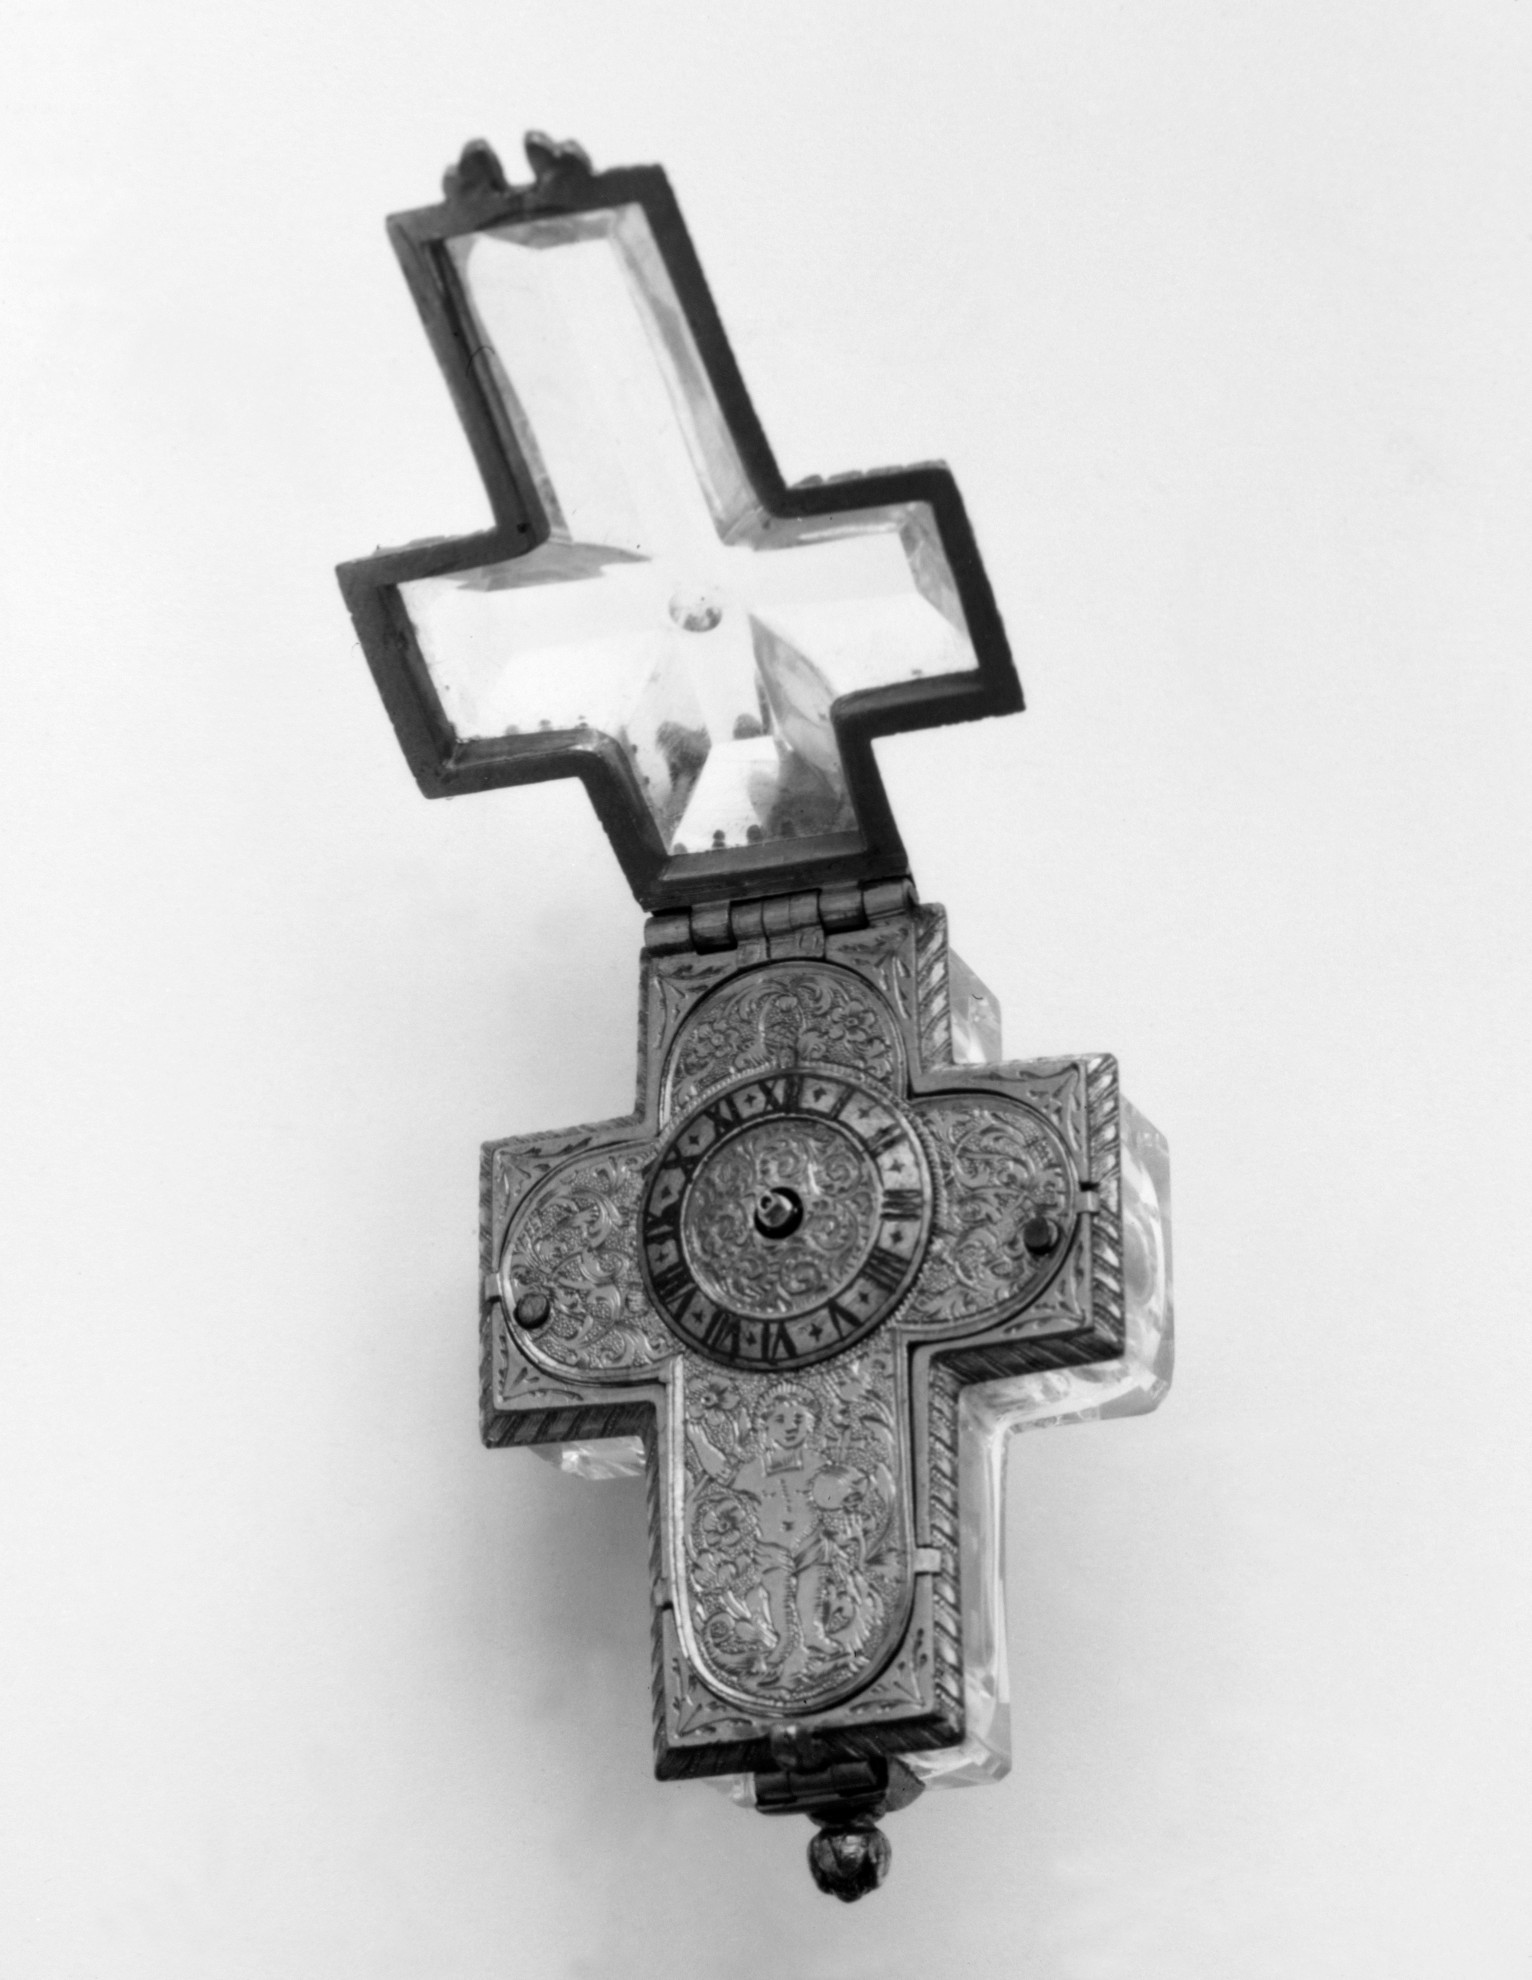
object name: watch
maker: a.r.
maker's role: maker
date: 1501-1600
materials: gilt, quartz, silver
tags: boys